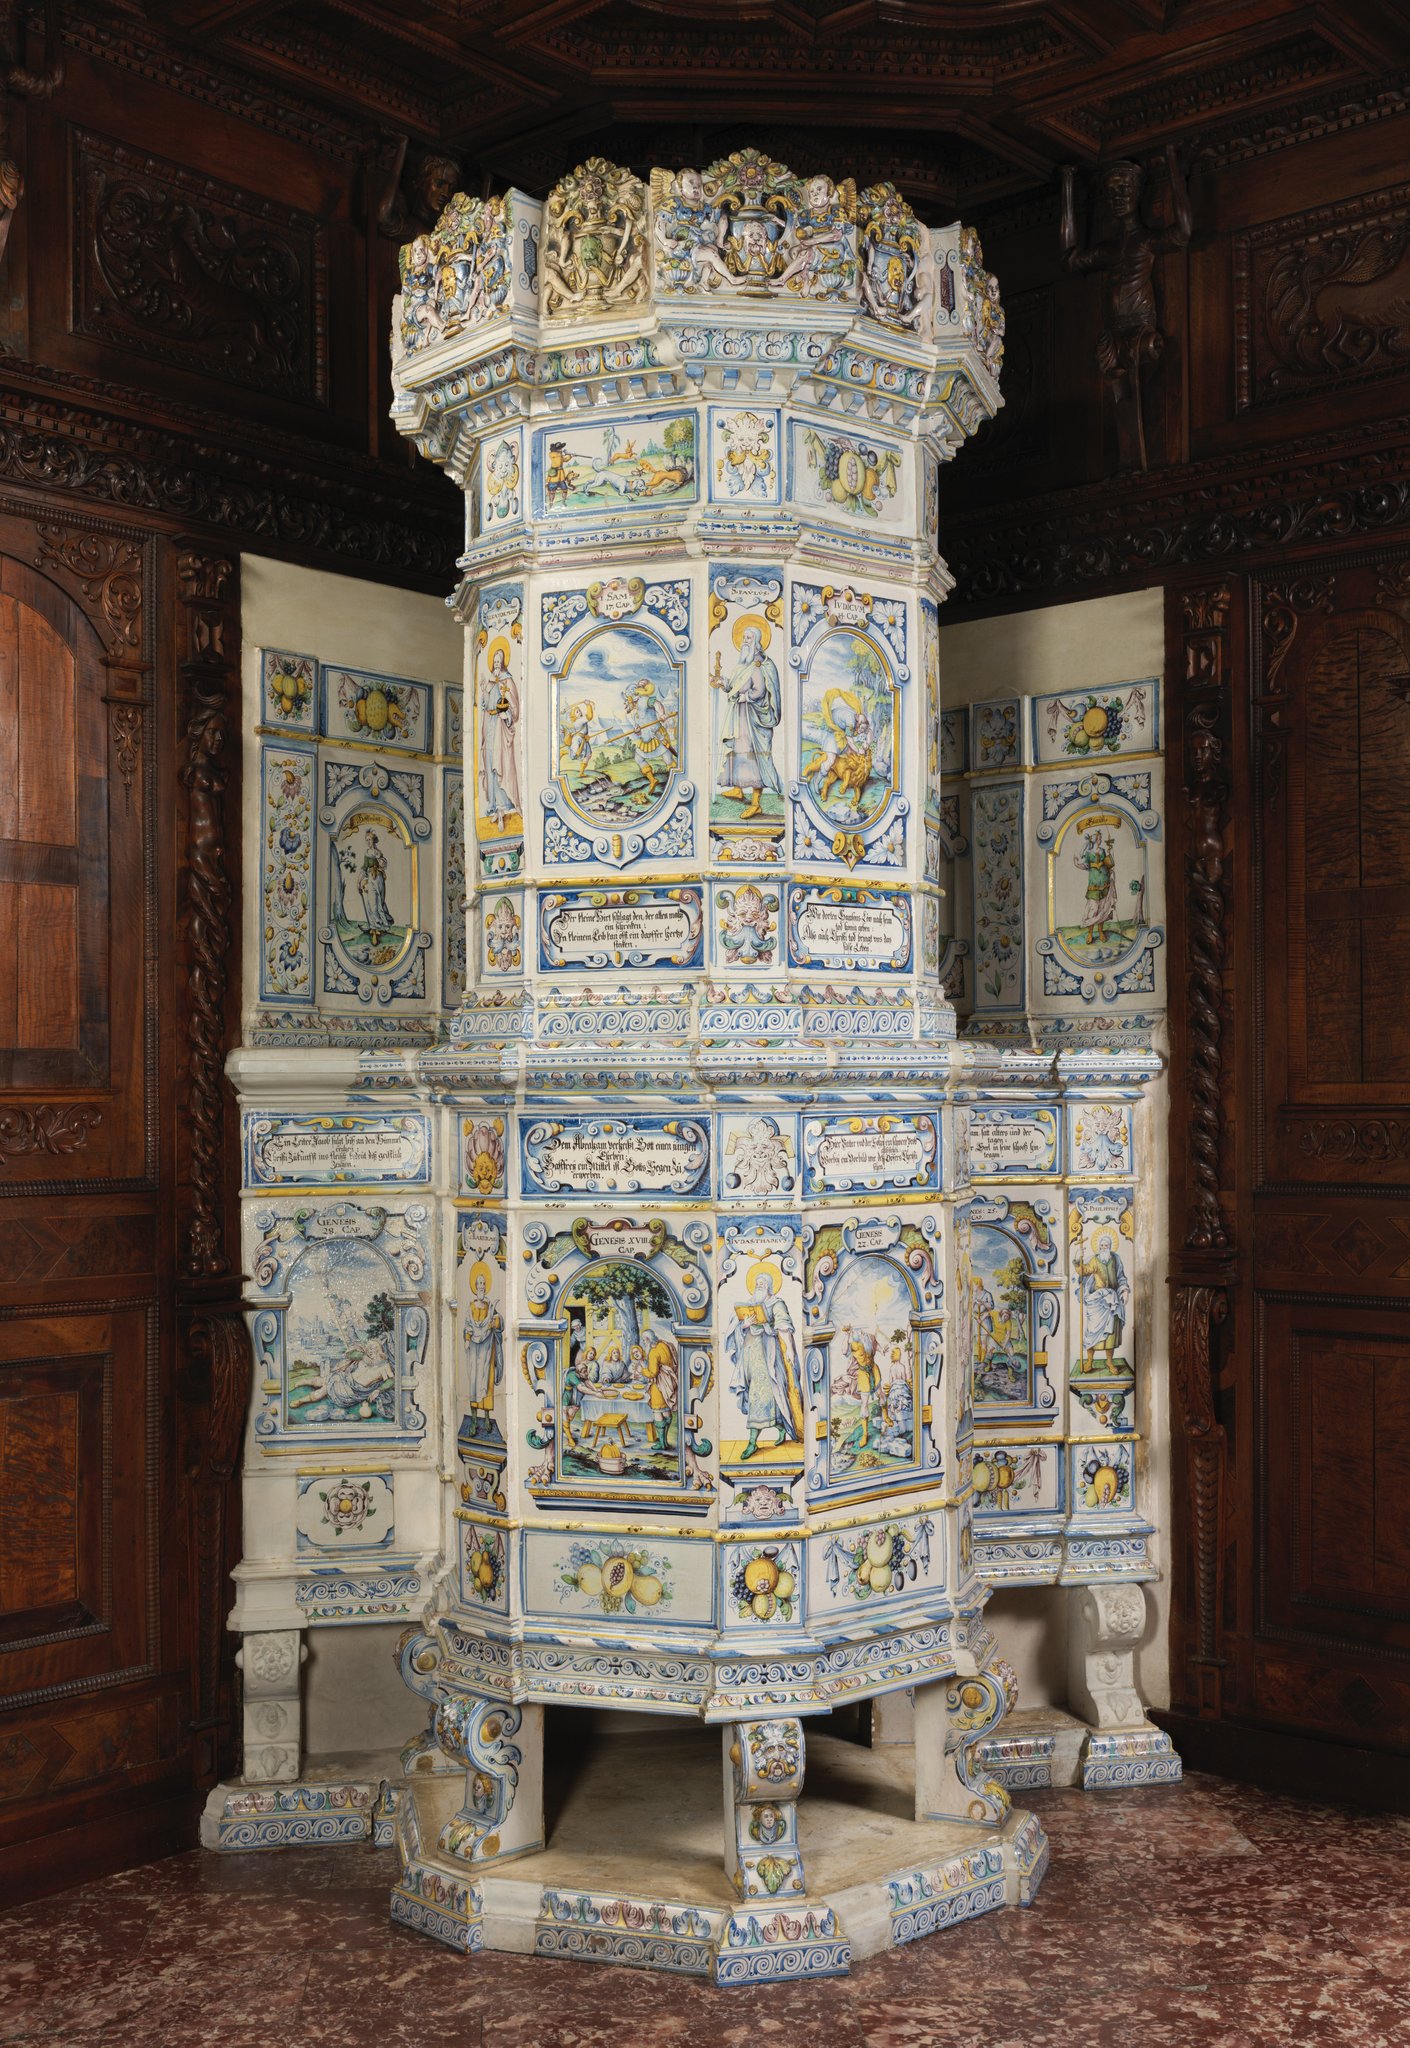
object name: stove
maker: david ii pfau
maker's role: maker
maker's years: 1644-1702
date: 1684-1685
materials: faience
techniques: glazing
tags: fruit,samson,abraham,david,goliath